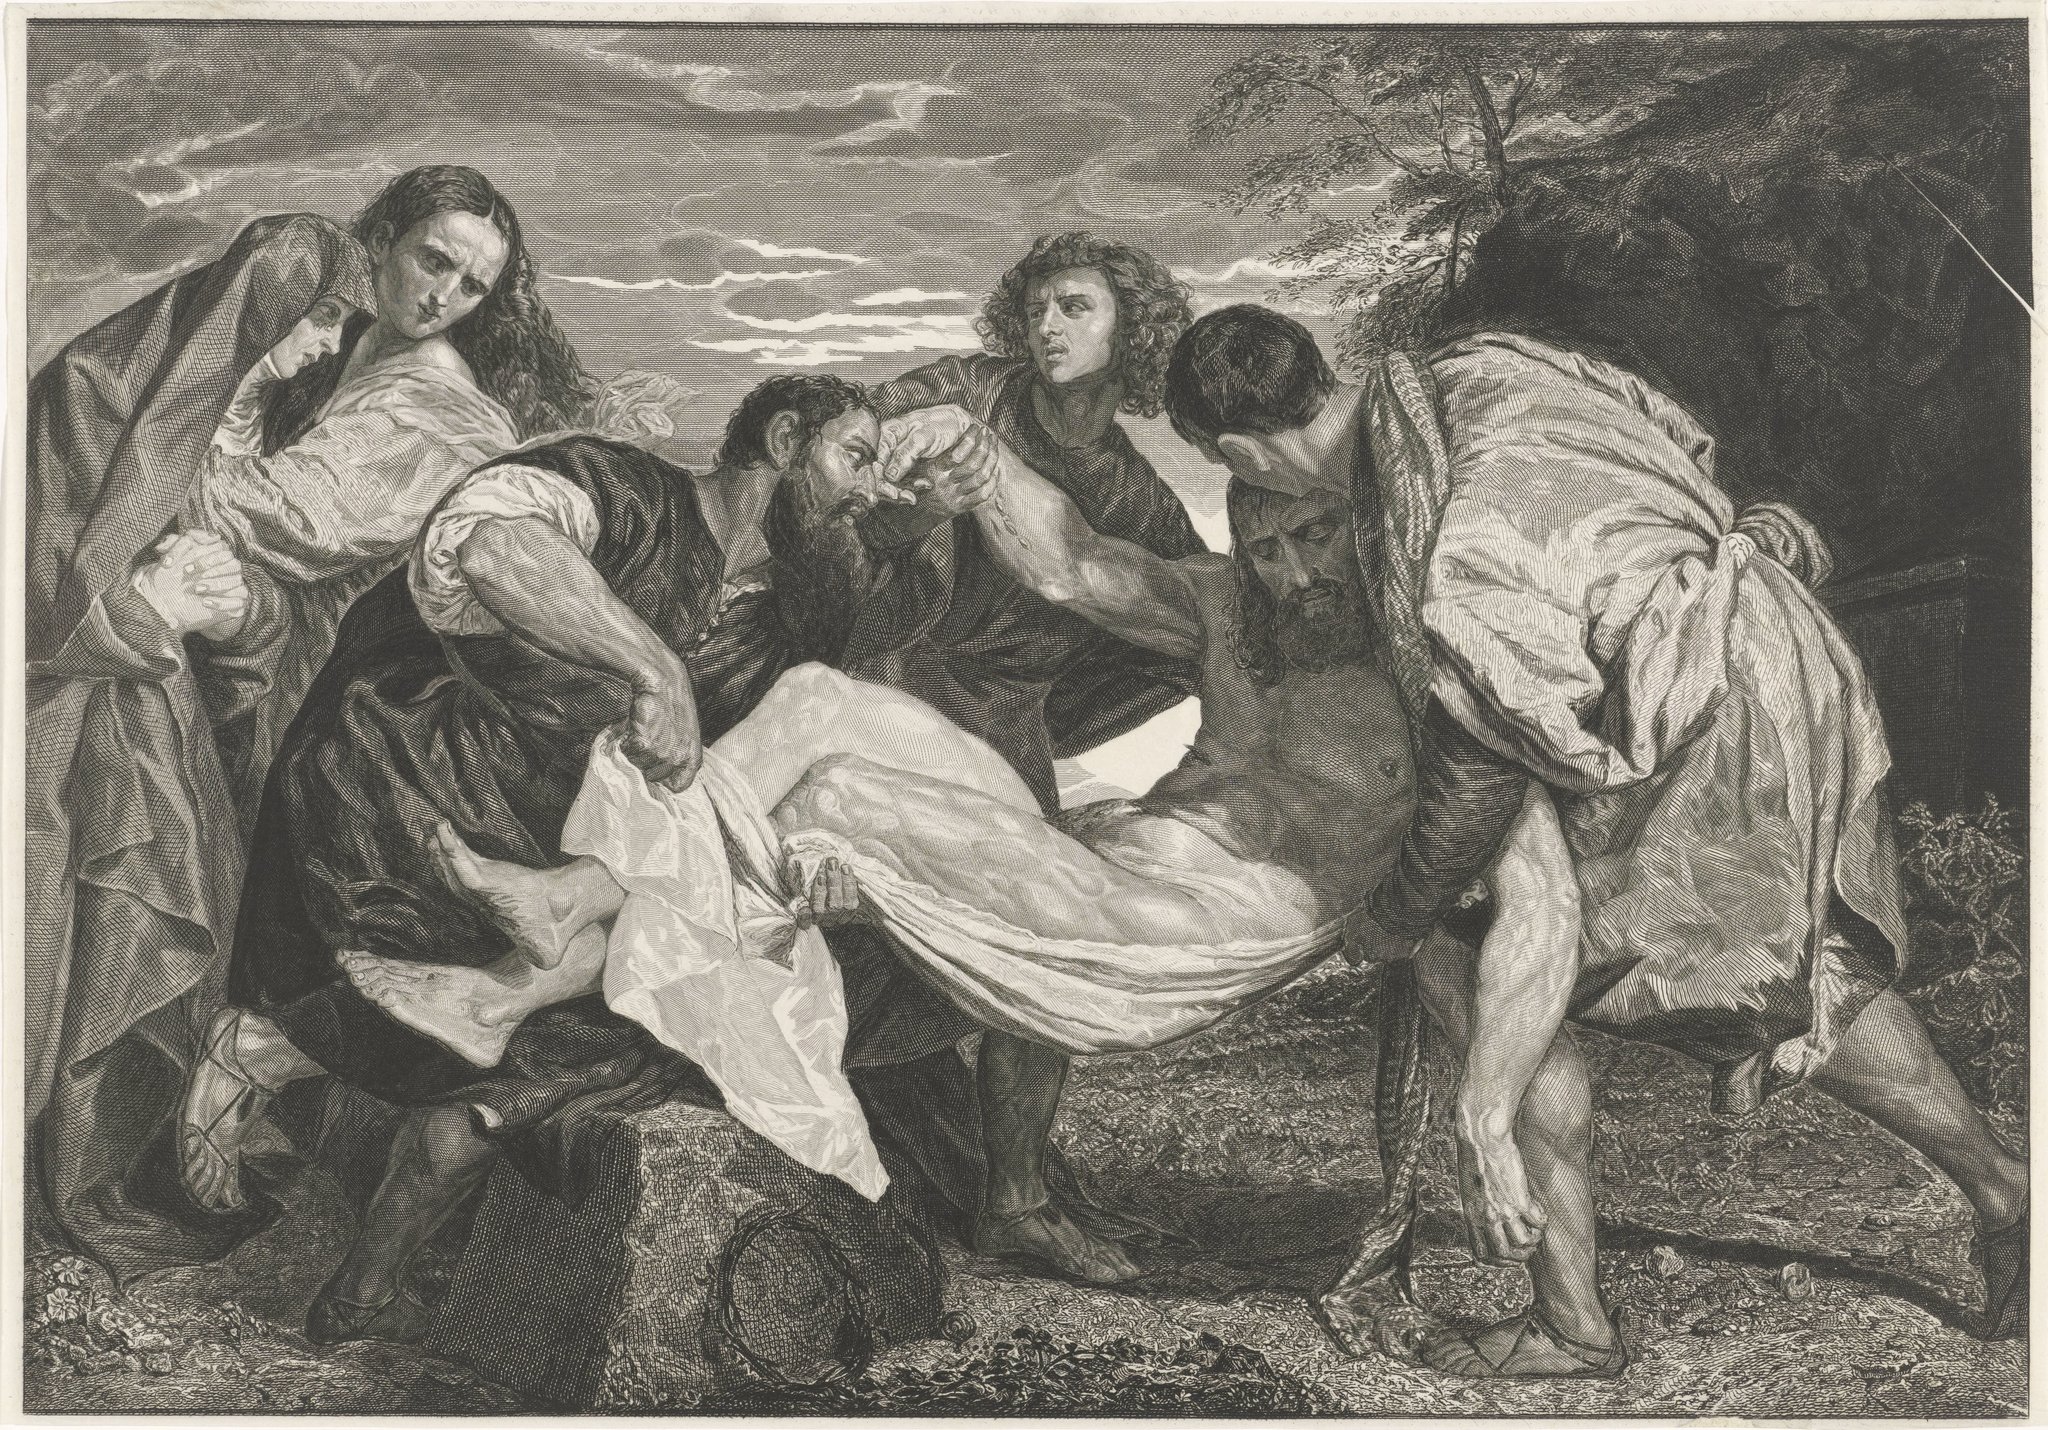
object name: print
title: Graflegging van Christus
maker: johannes de mare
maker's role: draughtsman, print maker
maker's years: 1806-1889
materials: paper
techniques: engraving, etching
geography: paris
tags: christ's entombment (possibly by angels)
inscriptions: collector's mark: Lugt 2228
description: De graflegging van Christus. Het lichaam van Christus wordt naar het graf gedragen door Jozef van Aritmathea, Nicodemus en een derde discipel. Johannes ondersteunt de Maria.